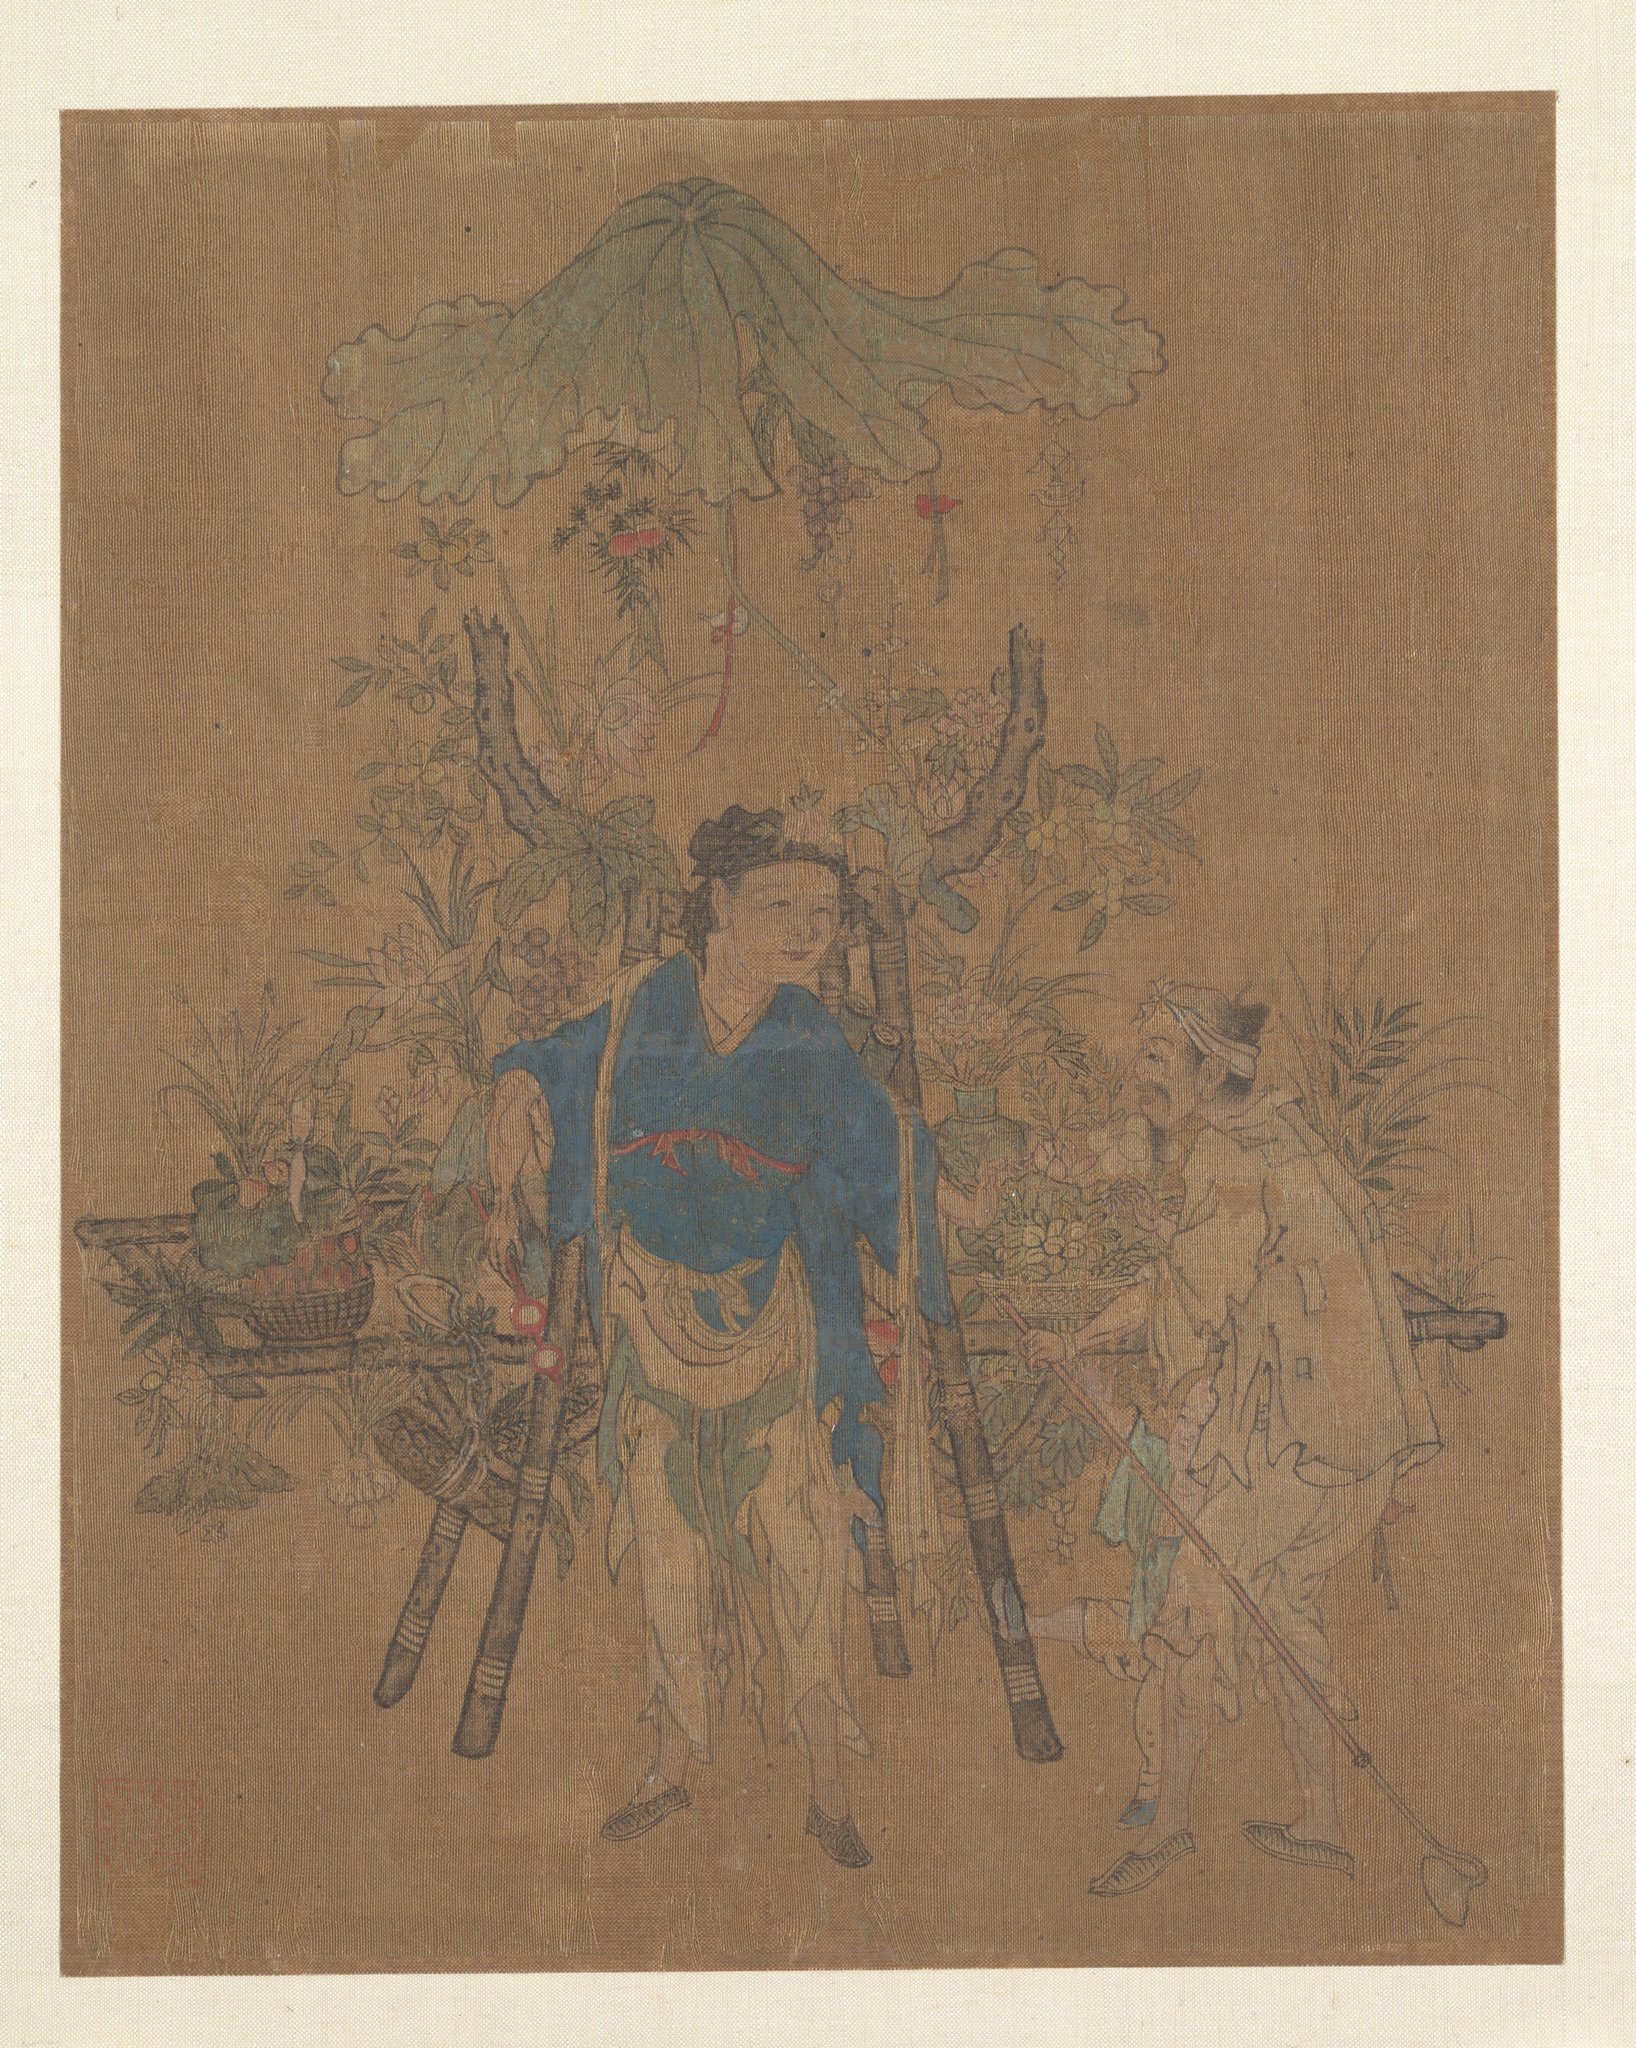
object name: album leaf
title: Flower Vendor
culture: chinese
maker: unidentified artist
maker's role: artist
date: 1368-1911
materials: ink, silk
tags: men,flowers